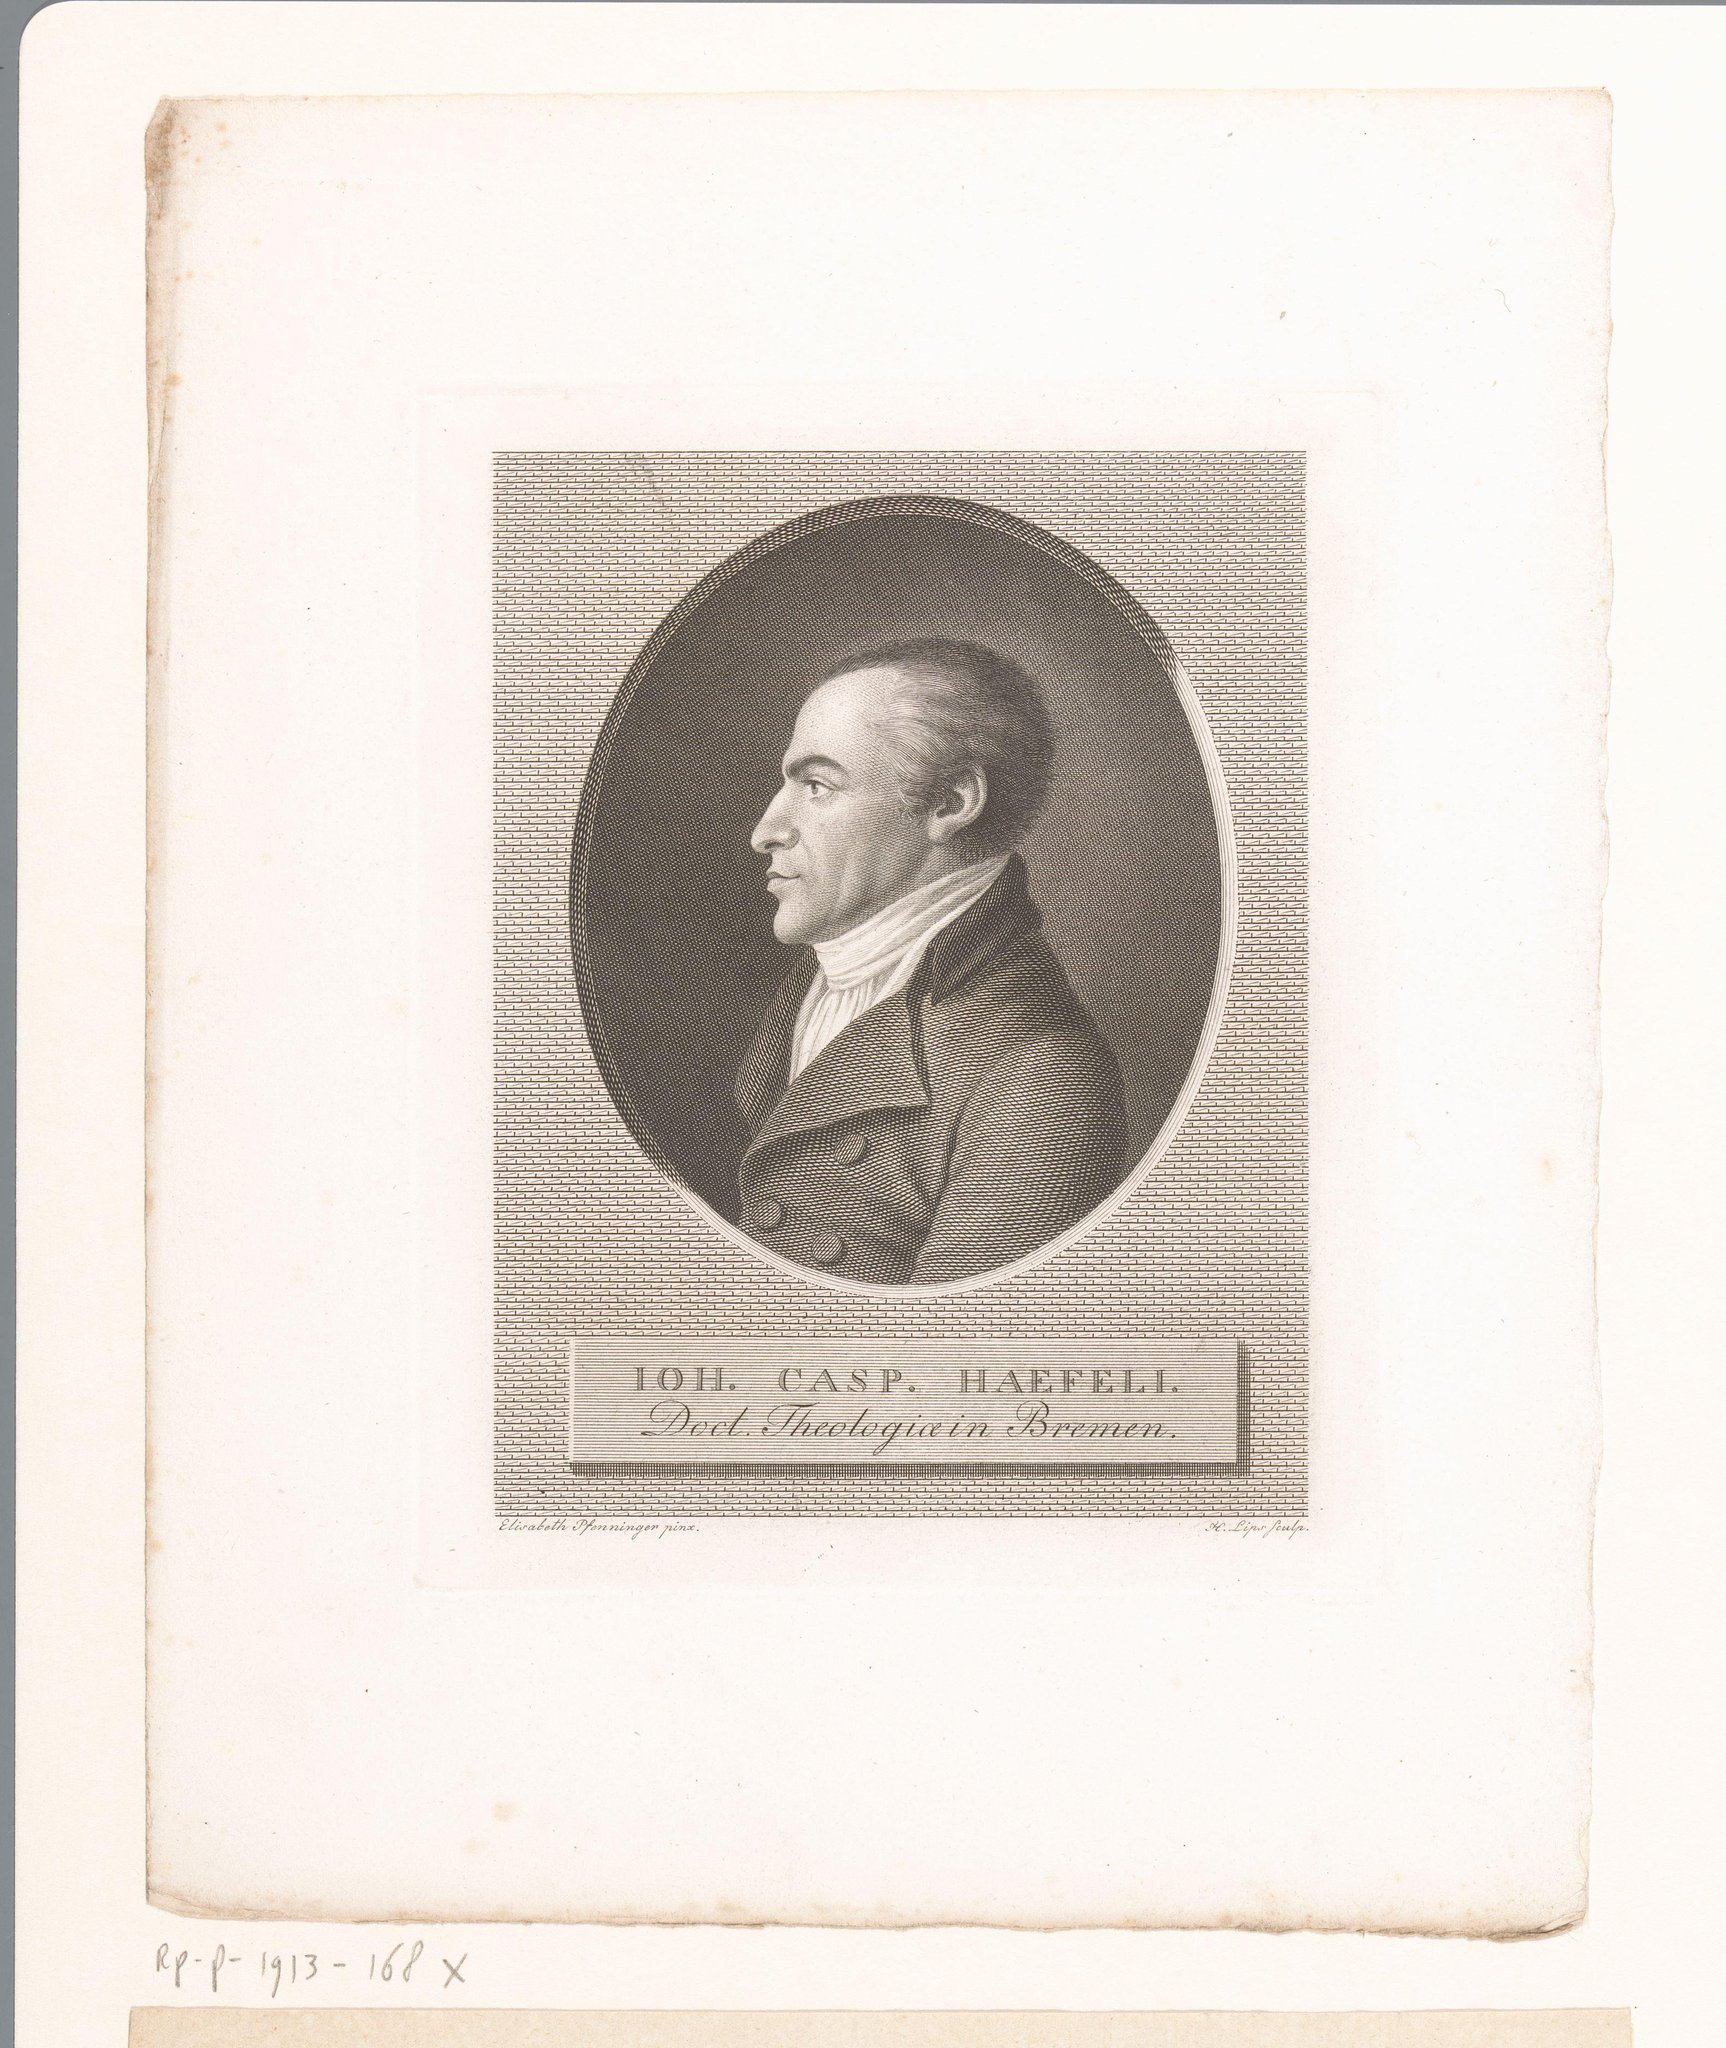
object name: print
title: Portret van Johann Caspar Haefeli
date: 1768-1817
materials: paper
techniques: engraving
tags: theologian, historical persons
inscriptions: collector's mark: Lugt 2228